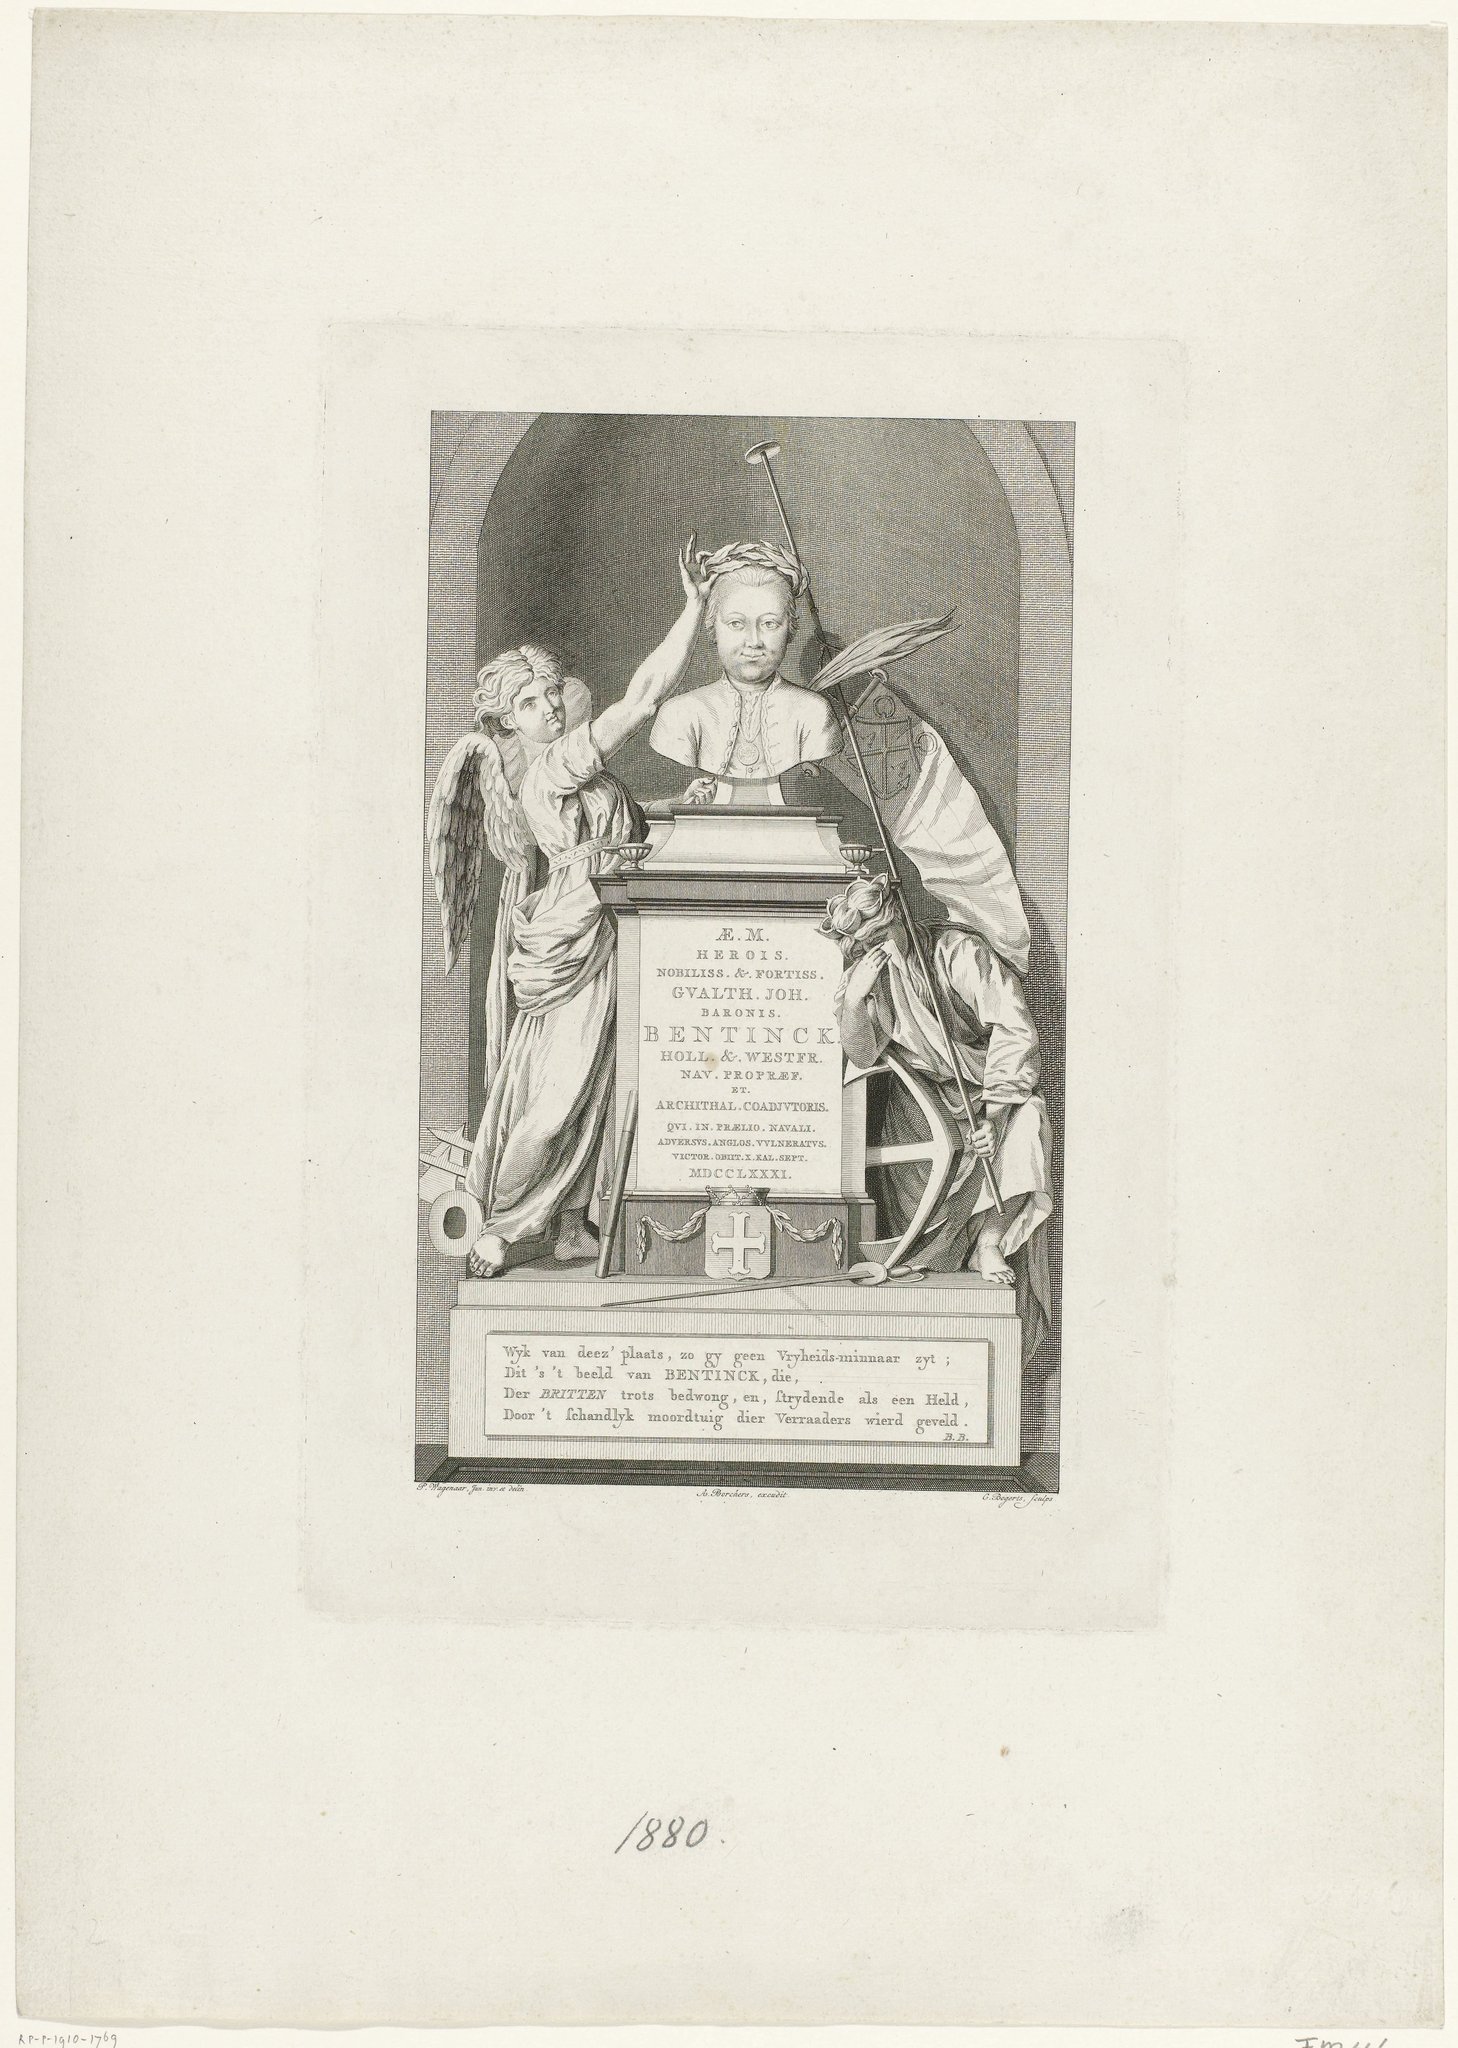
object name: print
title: Monument voor Wolter Jan Gerrit baron Bentinck, 1781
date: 1781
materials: paper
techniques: engraving, etching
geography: northern netherlands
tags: amsterdam, grave, tomb and other grave-forms and grave-markers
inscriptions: collector's mark: Lugt 2228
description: Allegorisch monument voor Wolter Jan Gerrit baron Bentinck, overleden 23/24 augustus en begraven op 28 augustus 1781 in de Nieuwe Kerk te Amsterdam. Een borstbeeld van een glimlachende Bentinck wordt door een engel met een lauwerkrans gekroond, rechts knielt een treurende vrouw met stedenkroon en vaandel van de admiraliteit van Amsterdam. Op het voetstuk een opschrift in het Latijn, onderaan een vierregelig vers.